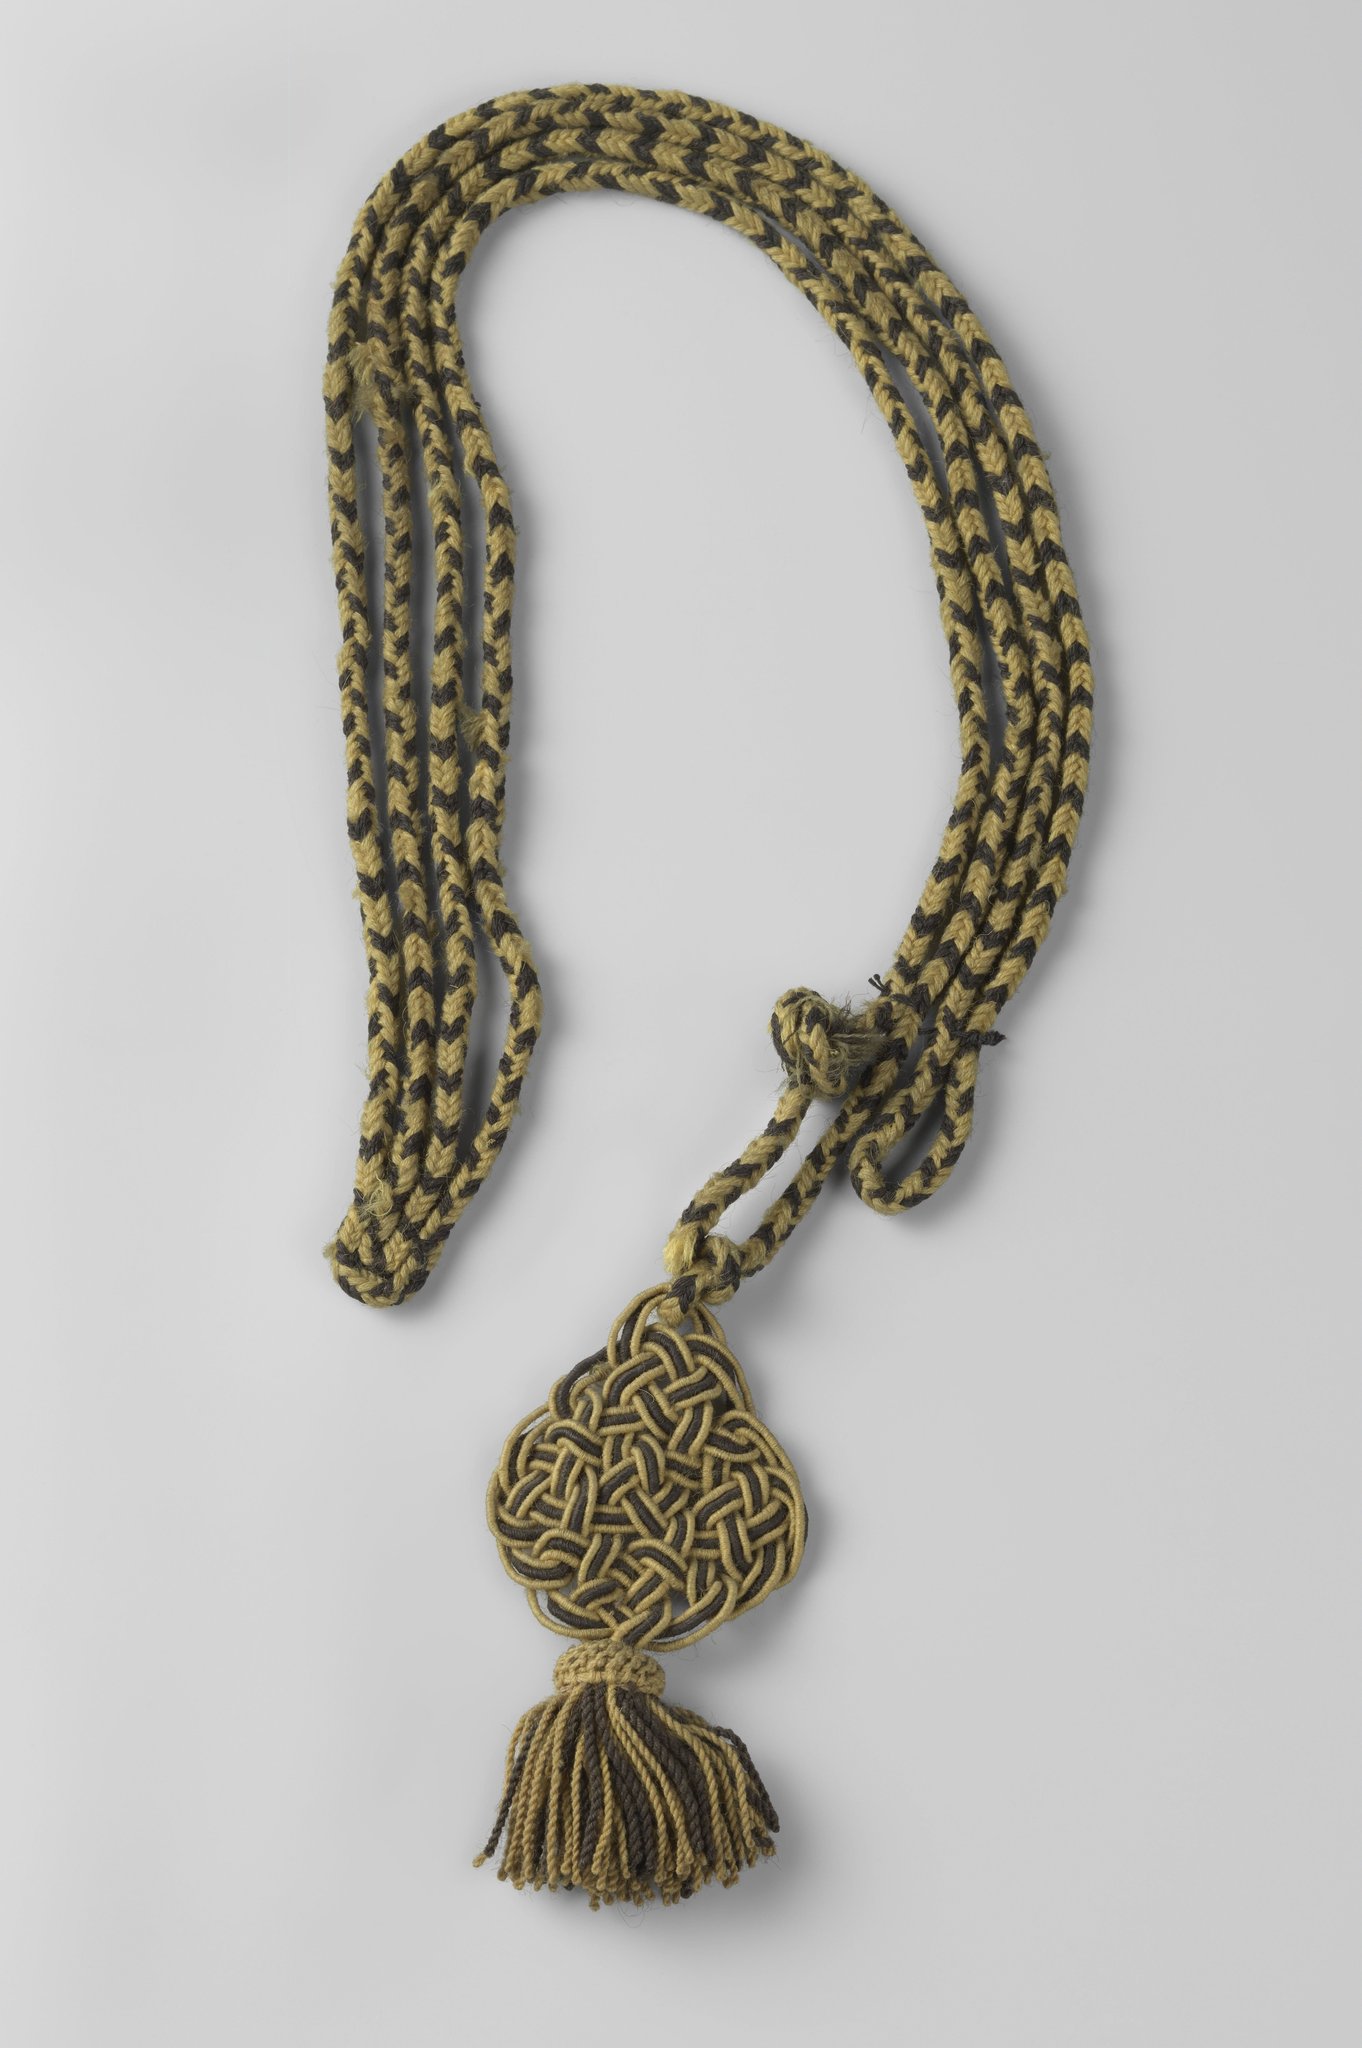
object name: snoer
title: Geel/ zwart vangsnoer bij een sjako van het regiment Huzaren nr. 8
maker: Anonymous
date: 1800-1850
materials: textile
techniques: braiding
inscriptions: : ‘8’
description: Vangsnoer van gele en zwarte gevlochten wol of katoen. Met één kwast en spiegel.